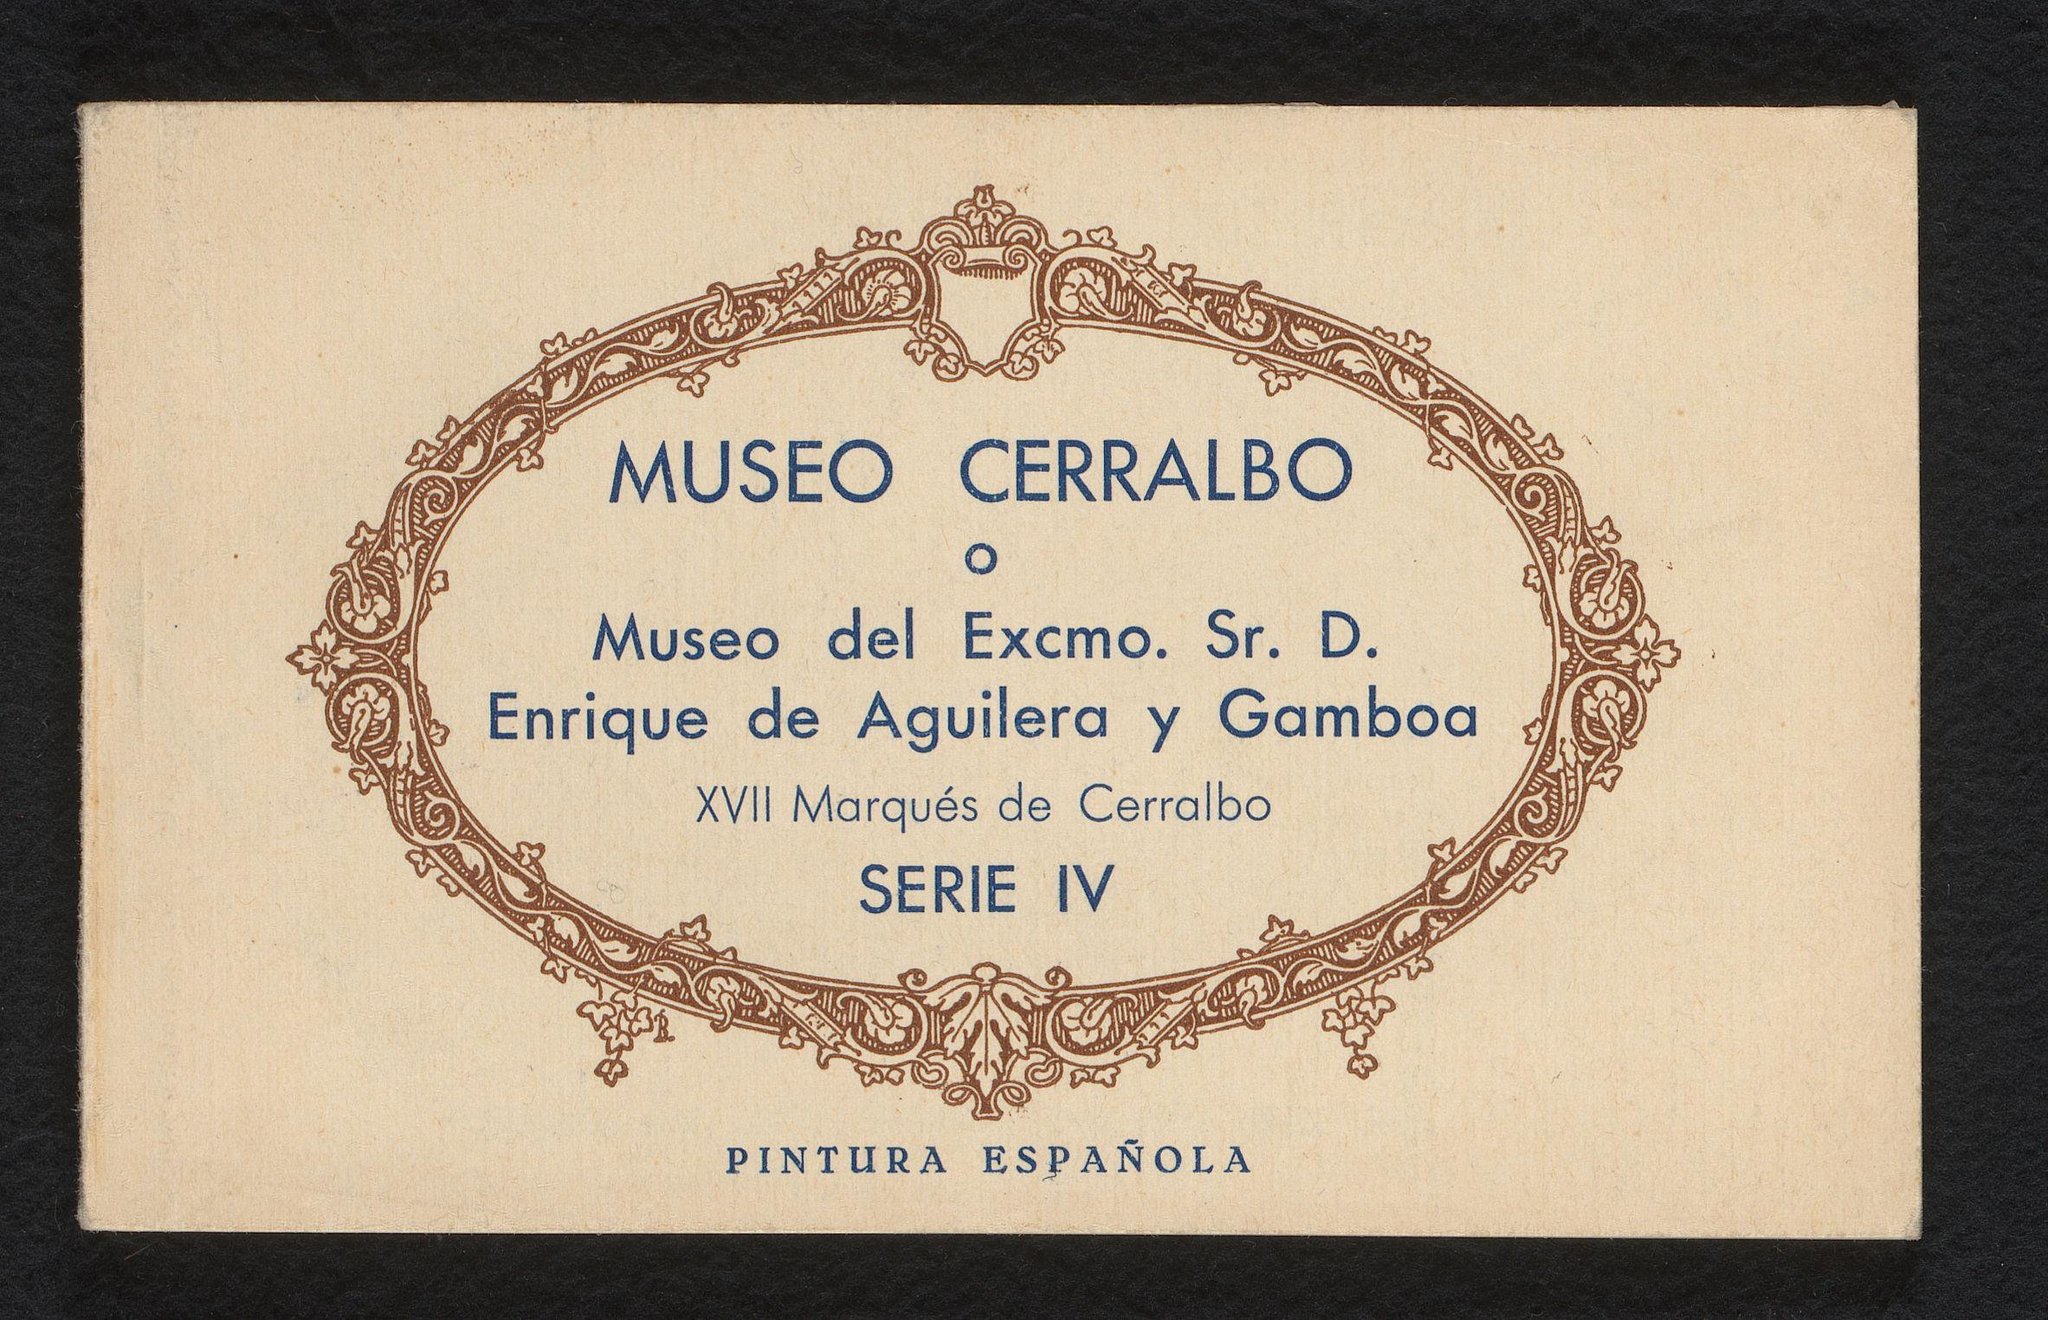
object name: album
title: Album met kunstreproducties uit het Museo Cerralbo te Madrid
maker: Anonymous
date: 1924-1930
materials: paper, cardboard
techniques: photograph, printing block, stapling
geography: madrid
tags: picture, painting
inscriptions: collector's mark: ‘AFE v S’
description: Album met twintig prentbriefkaarten met kunstreproducties uit het Museo Cerralbo te Madrid. De prentbriefkaarten kunnen eruit gescheurd worden.